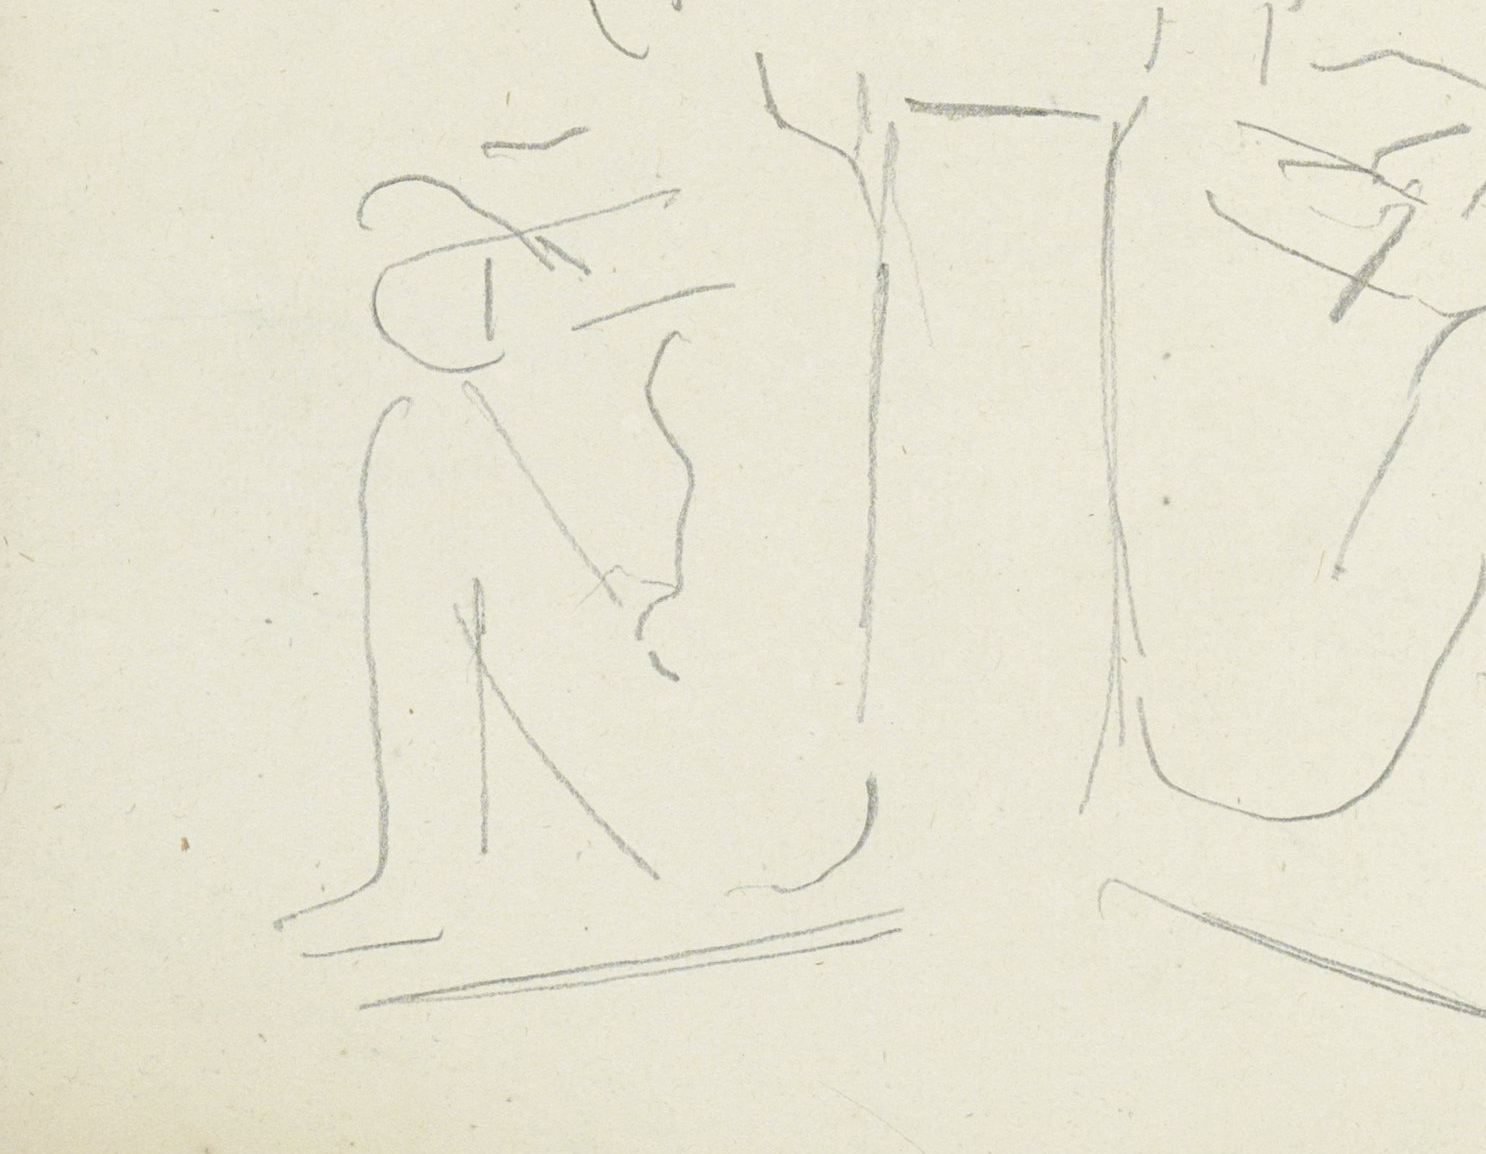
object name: sketchbook leaf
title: Ornament met twee zittende figuren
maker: carel adolph lion cachet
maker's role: draughtsman, print maker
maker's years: 1864-1945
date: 1928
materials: paper, pencil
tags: ornaments ~ art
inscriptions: annotation: ‘[...]’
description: De figuren zitten met de knieën opgetrokken. Blad 18 verso uit een schetsboek met 24 bladen.